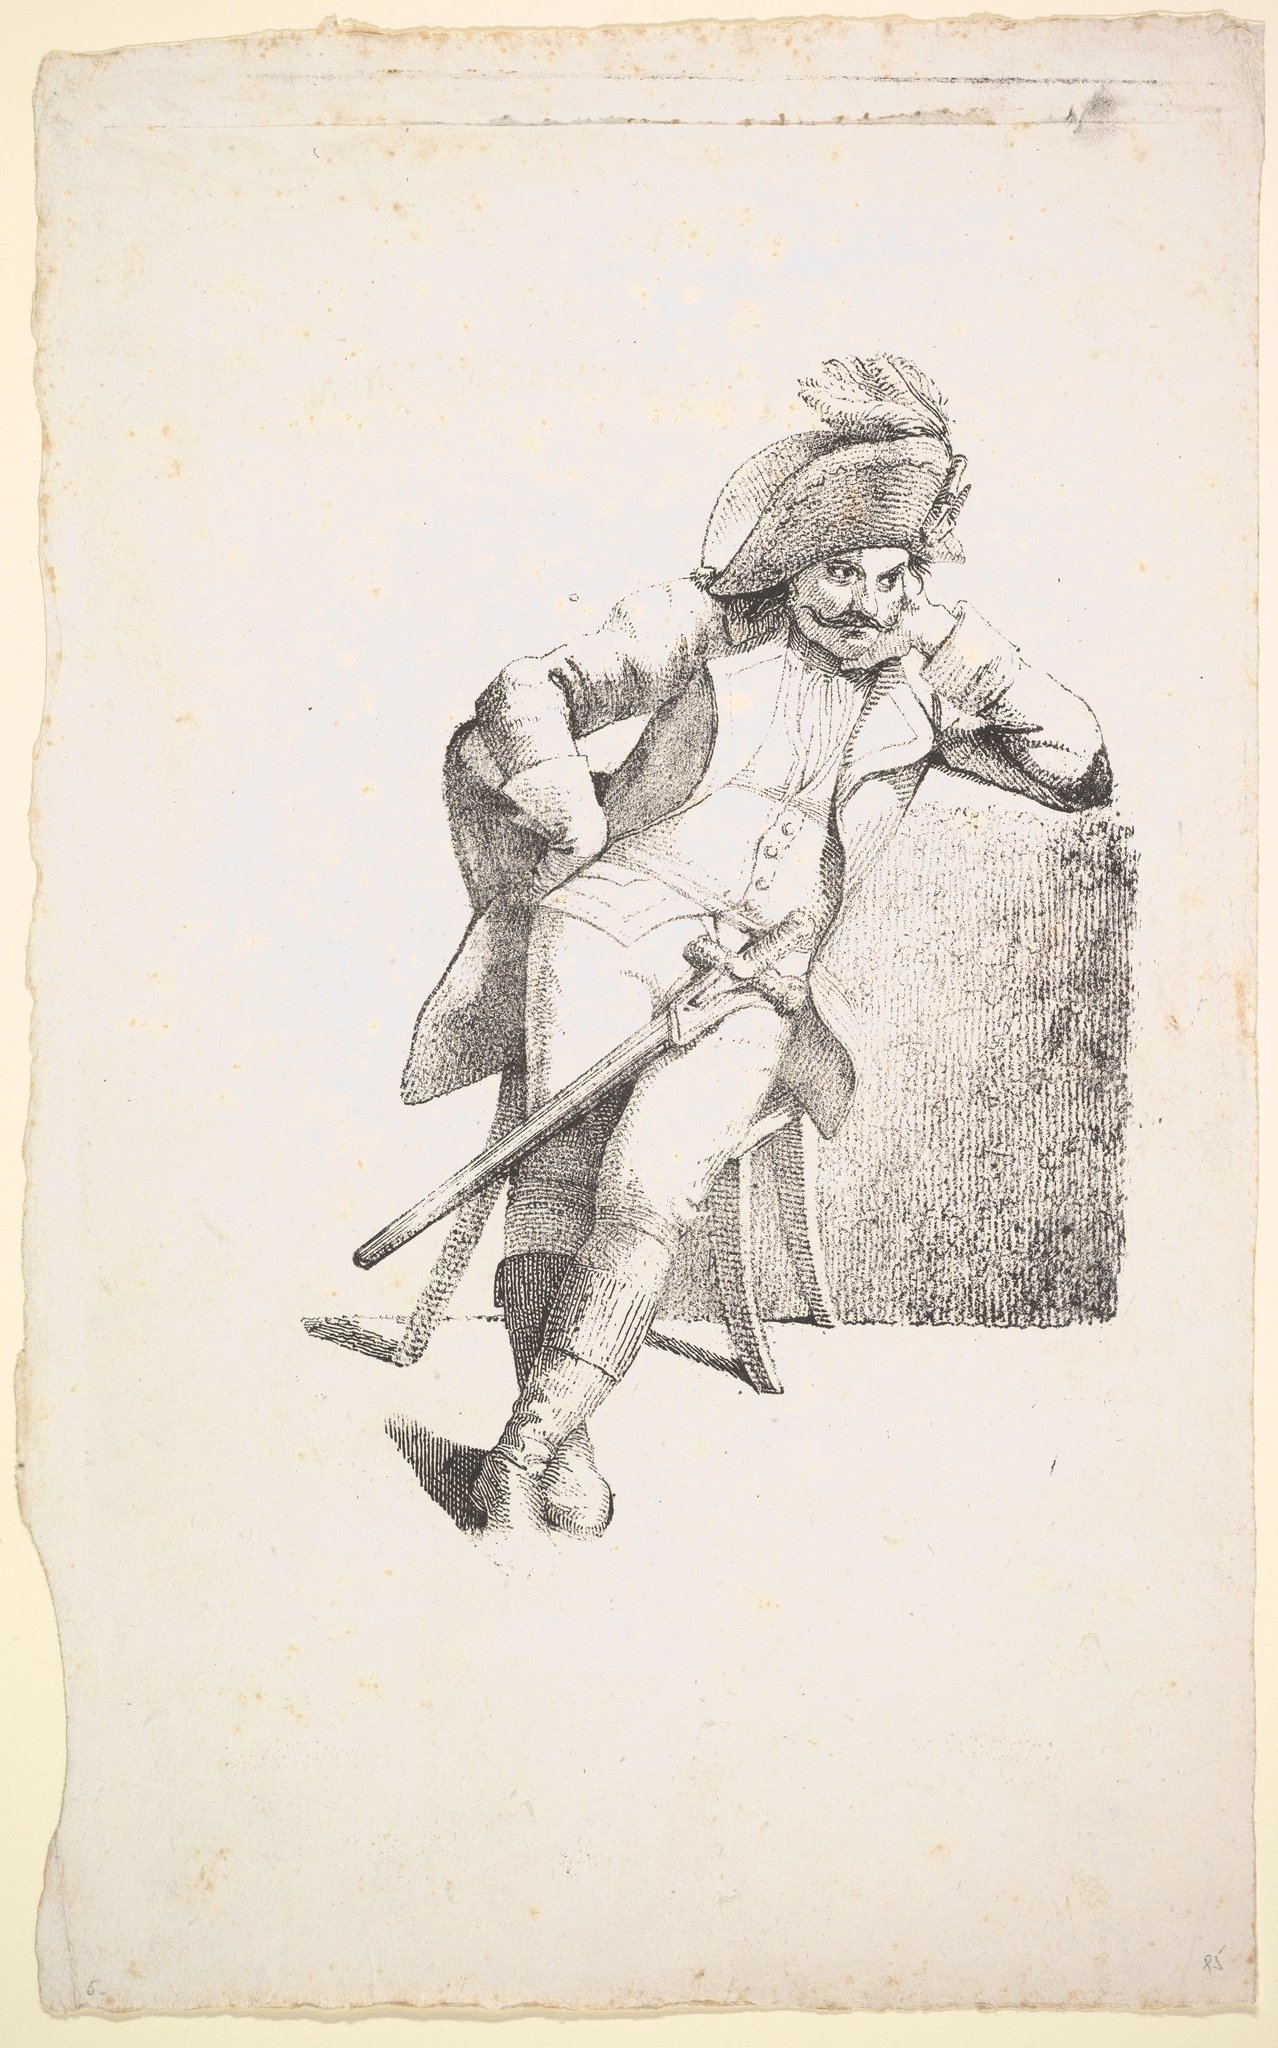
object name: print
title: The Thoughtful Captain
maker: johann gottfried schadow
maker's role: artist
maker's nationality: german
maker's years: 1764-1850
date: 1822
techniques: lithograph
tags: soldiers,contemplation,men